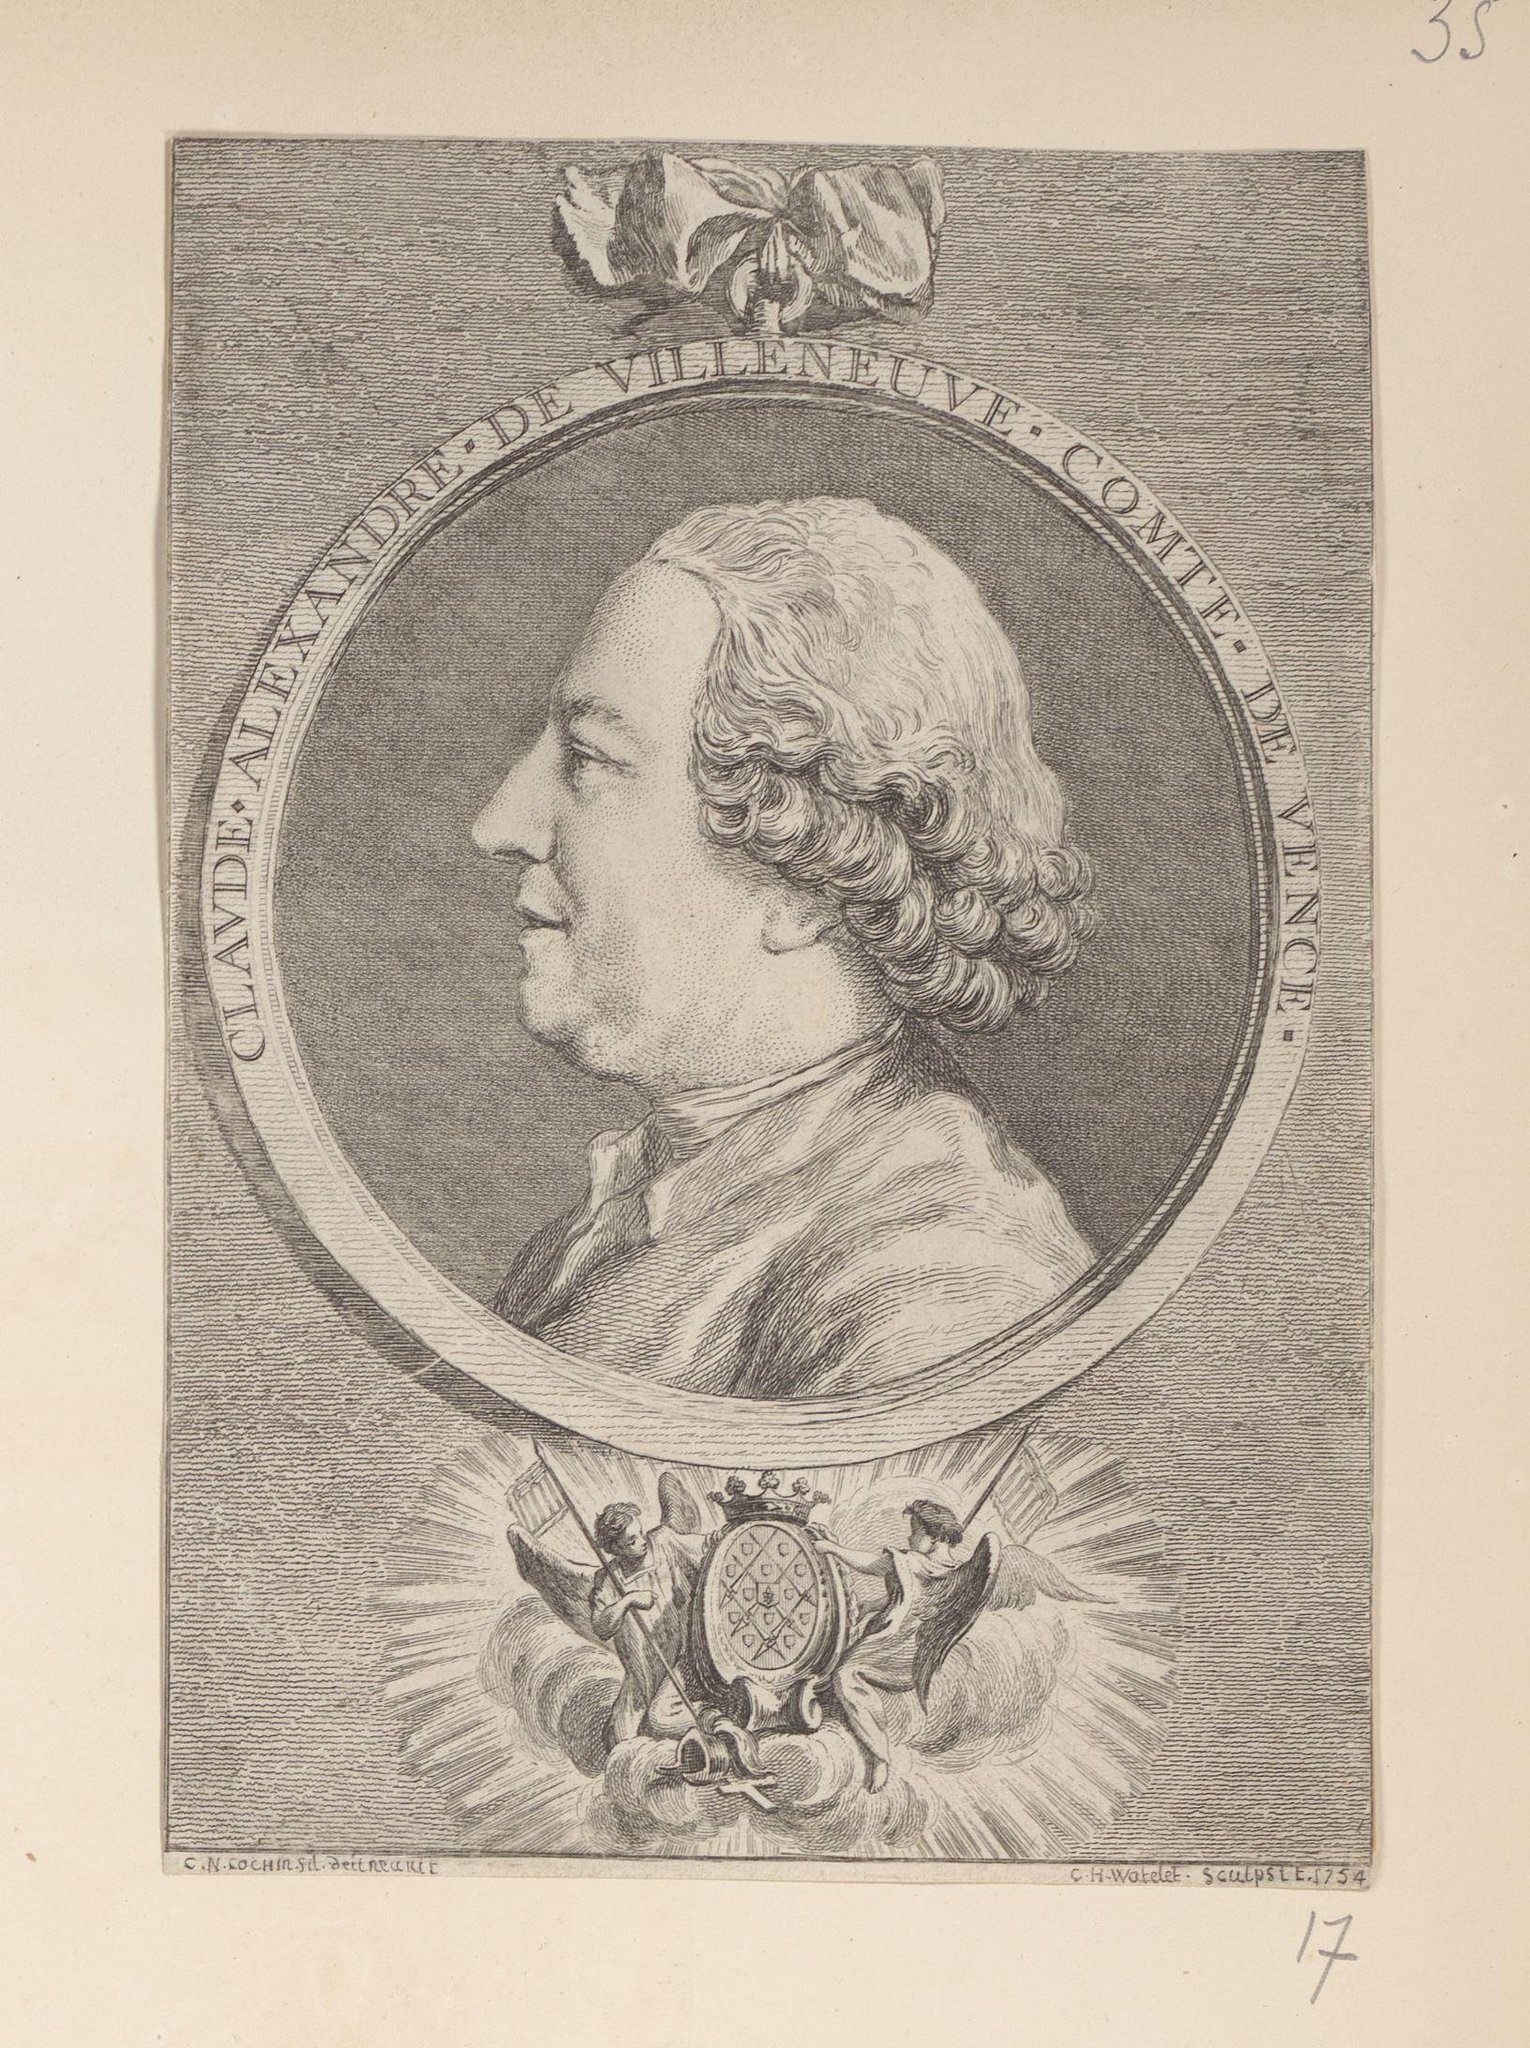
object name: print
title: Claude Alexandre de Villeneuve Comte de Vence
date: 1754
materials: paper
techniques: engraving, etching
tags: claude-alexander de villeneuve (comte de vence), historical persons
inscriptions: date